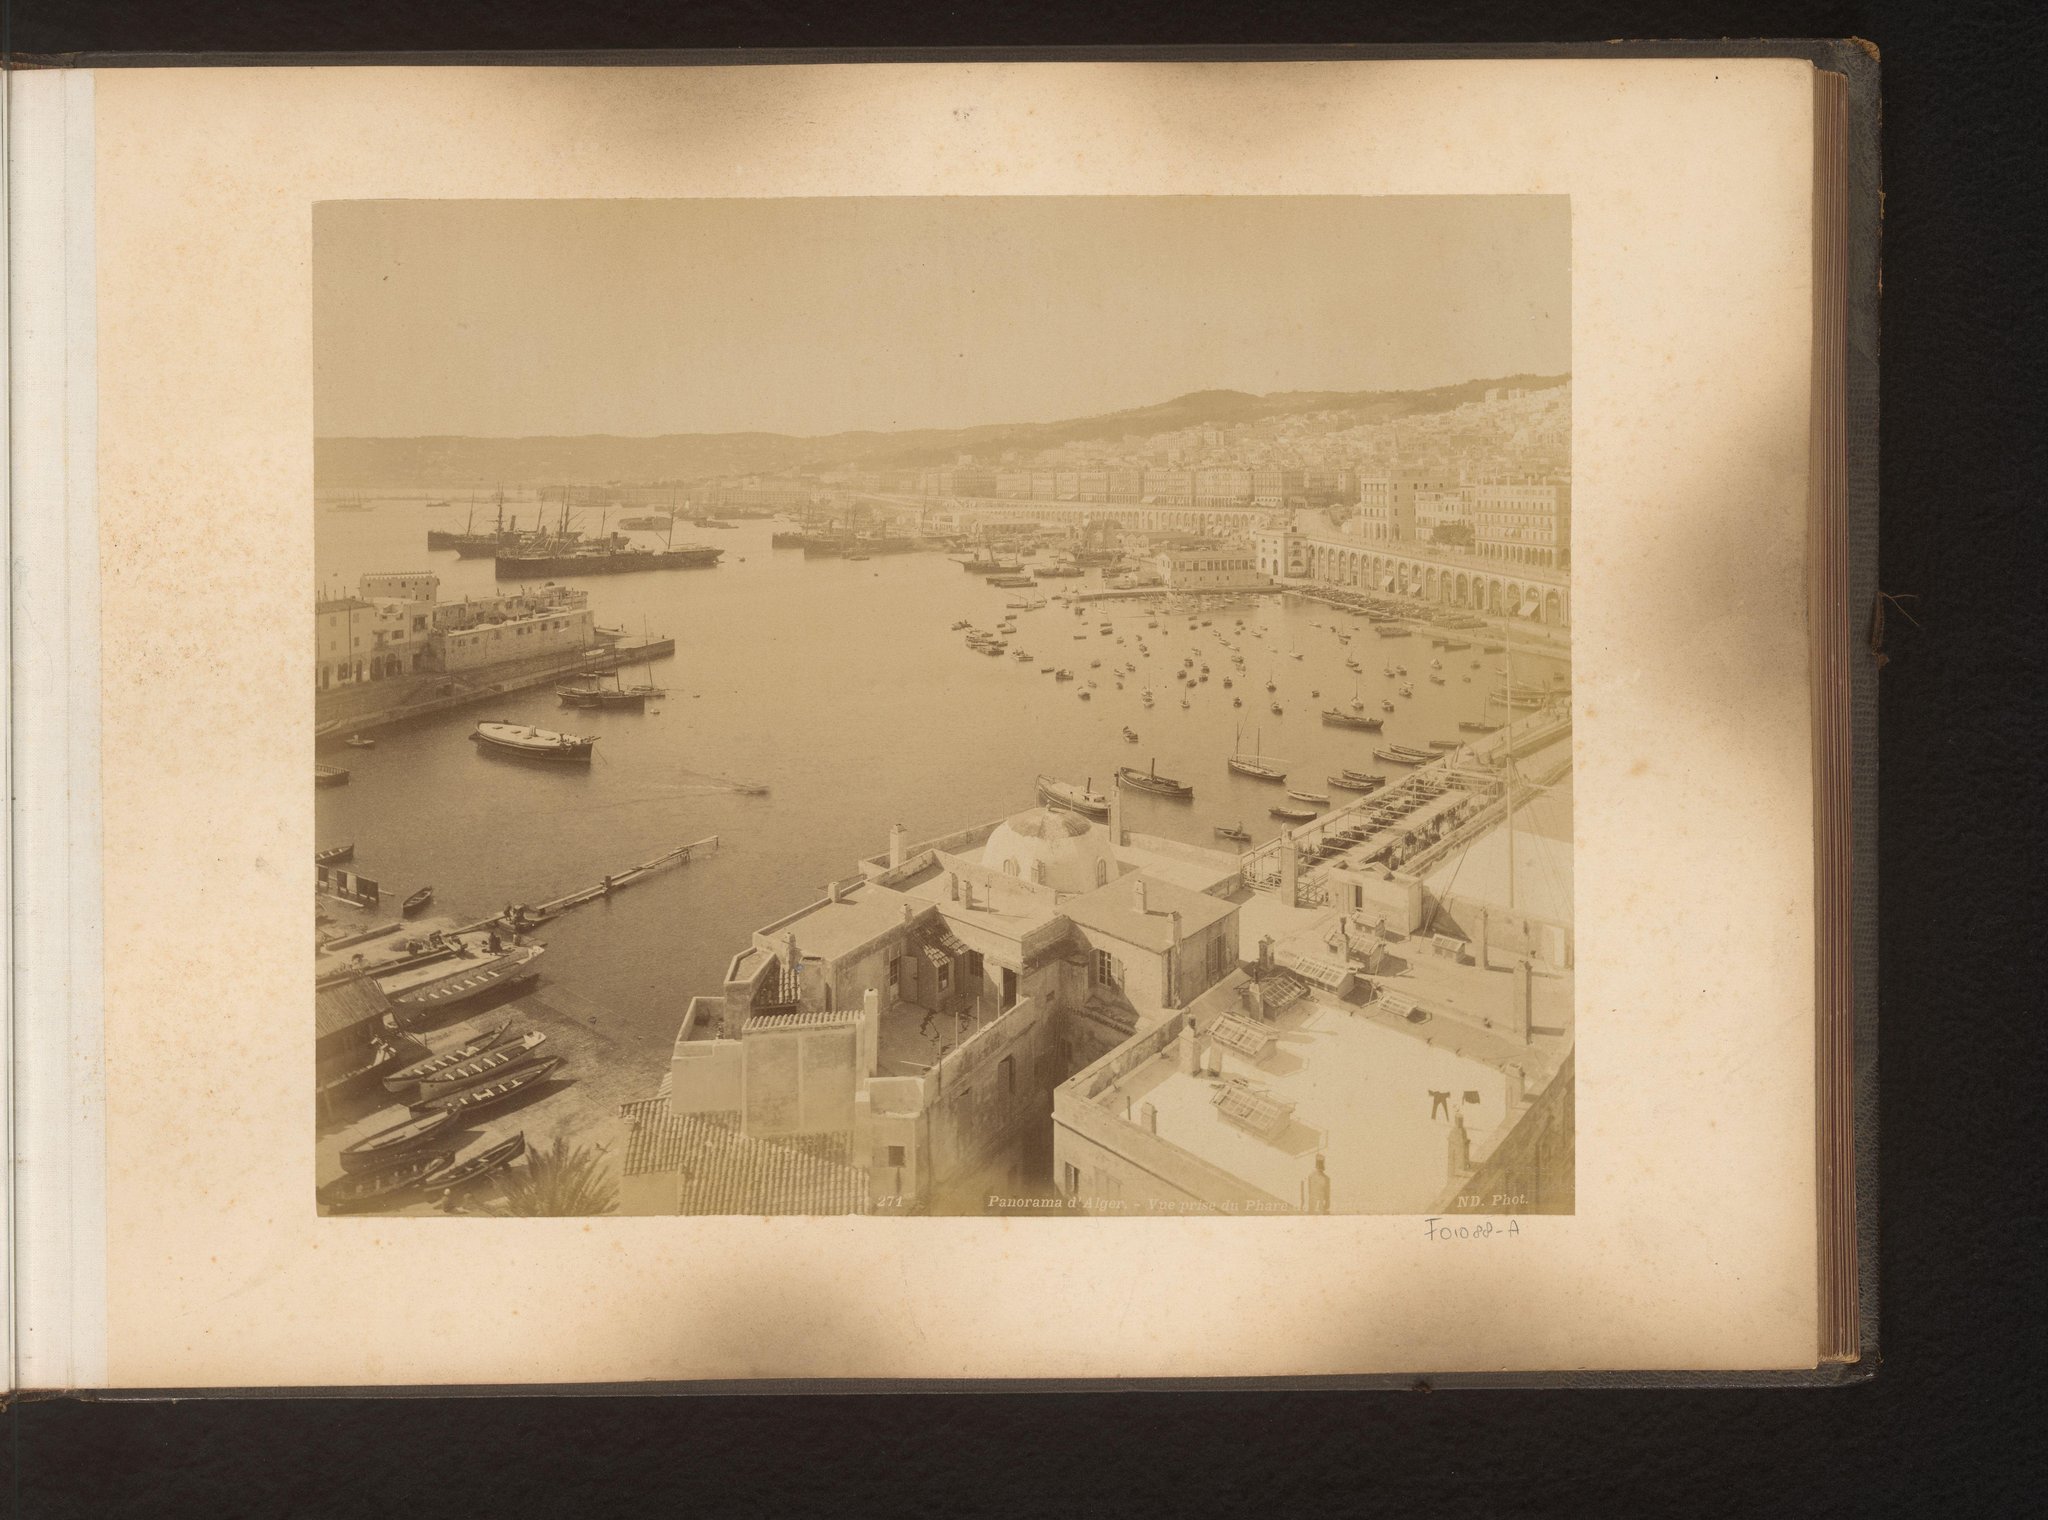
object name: album leaf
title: Panorama van de haven van Algiers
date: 1880-1900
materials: photographic support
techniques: albumen print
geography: algiers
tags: harbour, prospect of city, town panorama, silhouette of city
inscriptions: check stamp: ‘J. Kuhn Editeur/ 220 Rue de Rivoli Paris’, number: ‘271’